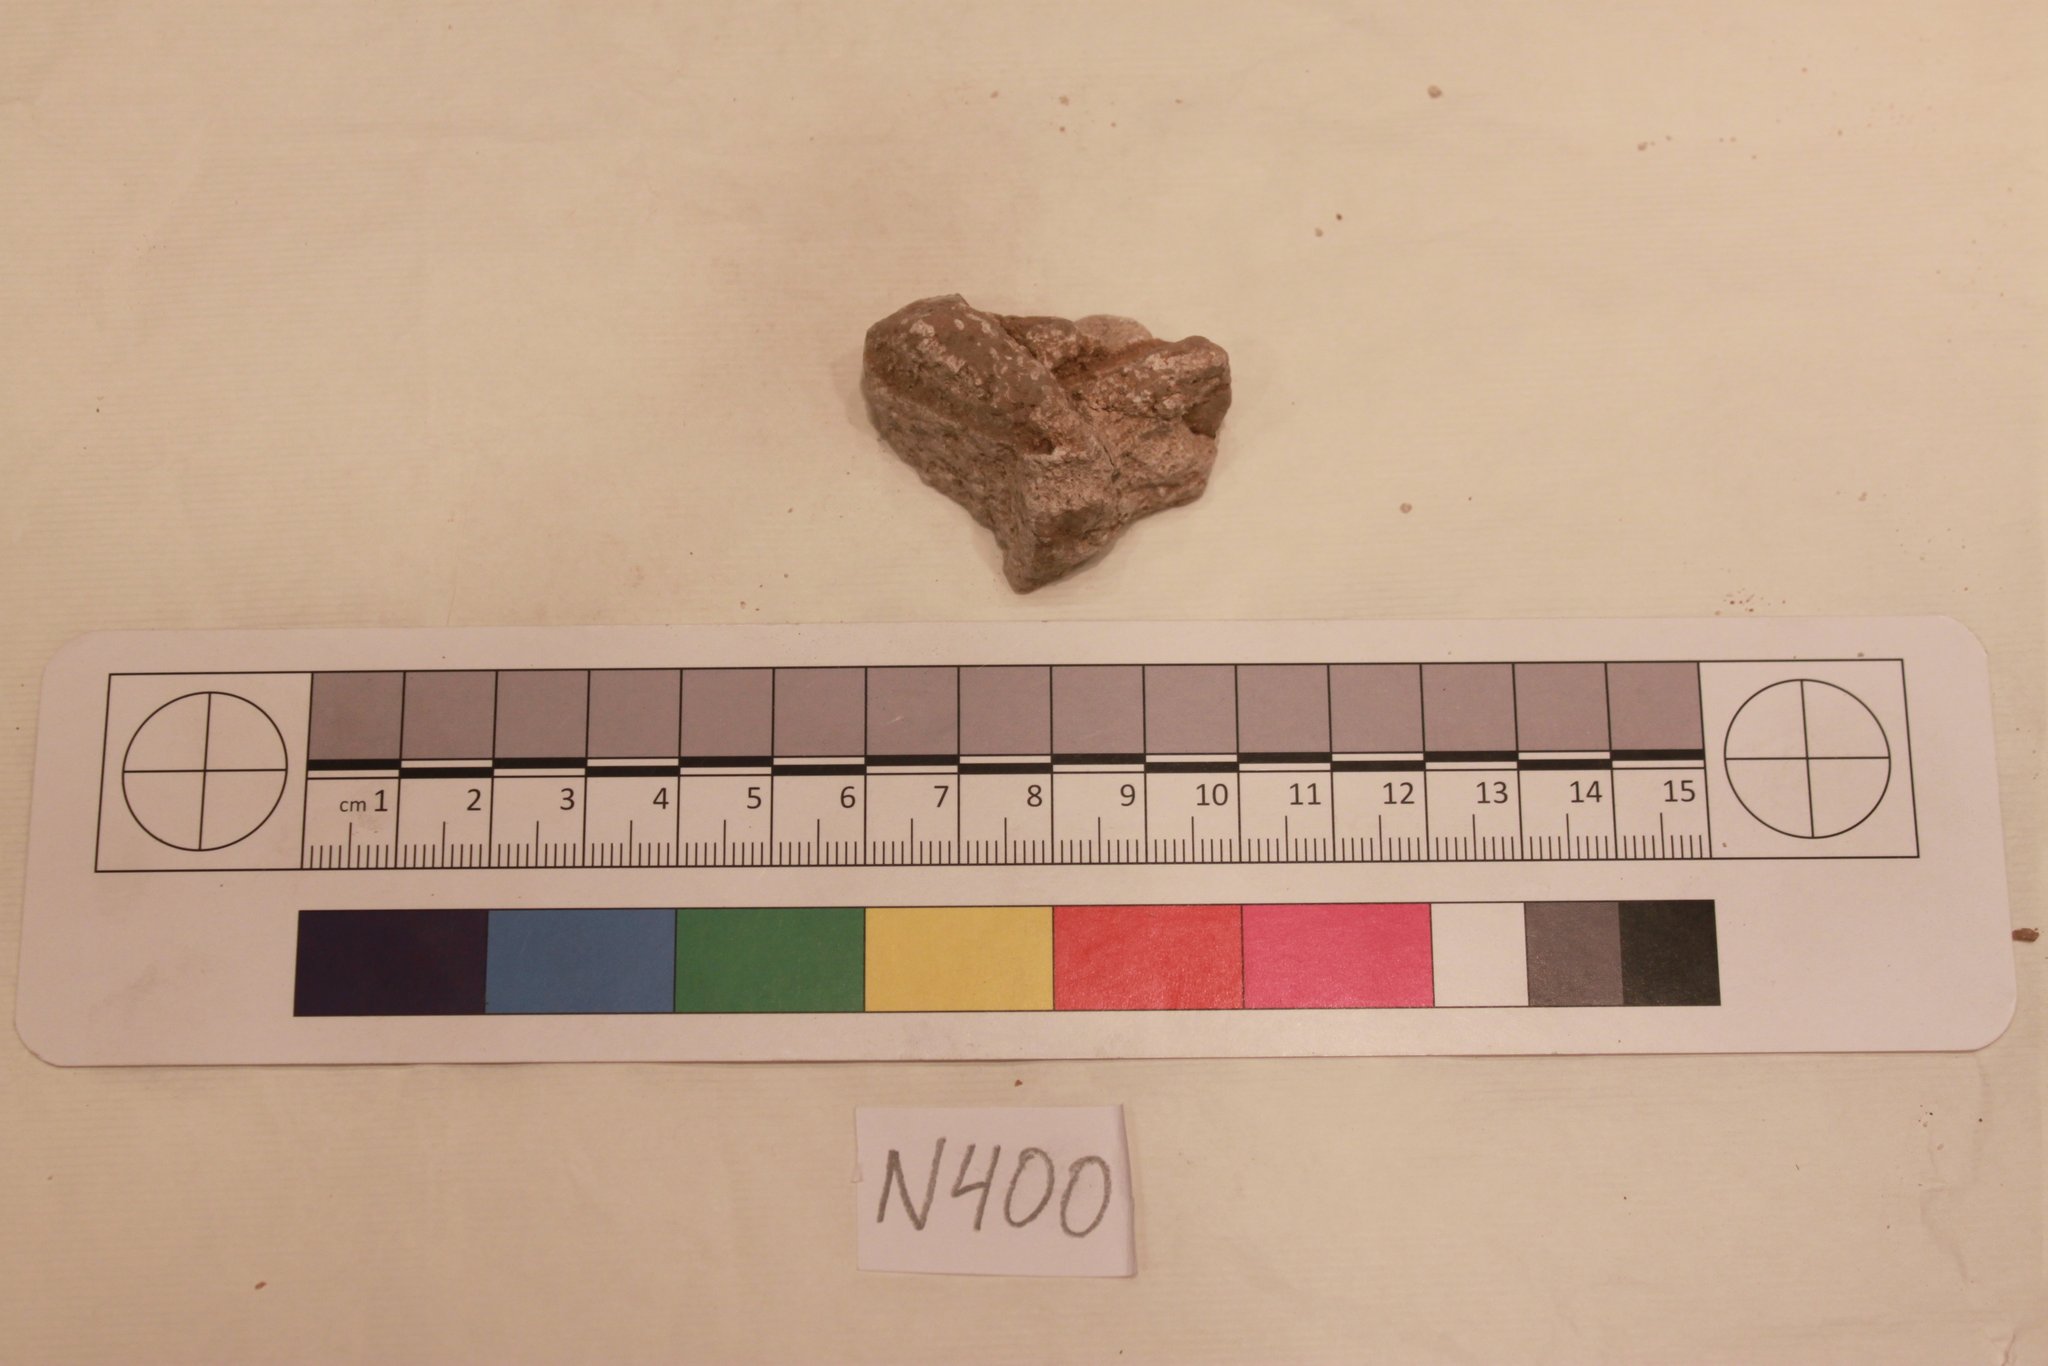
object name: fragment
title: Stucco Fragment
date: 701-1200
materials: plaster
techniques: carving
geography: iran